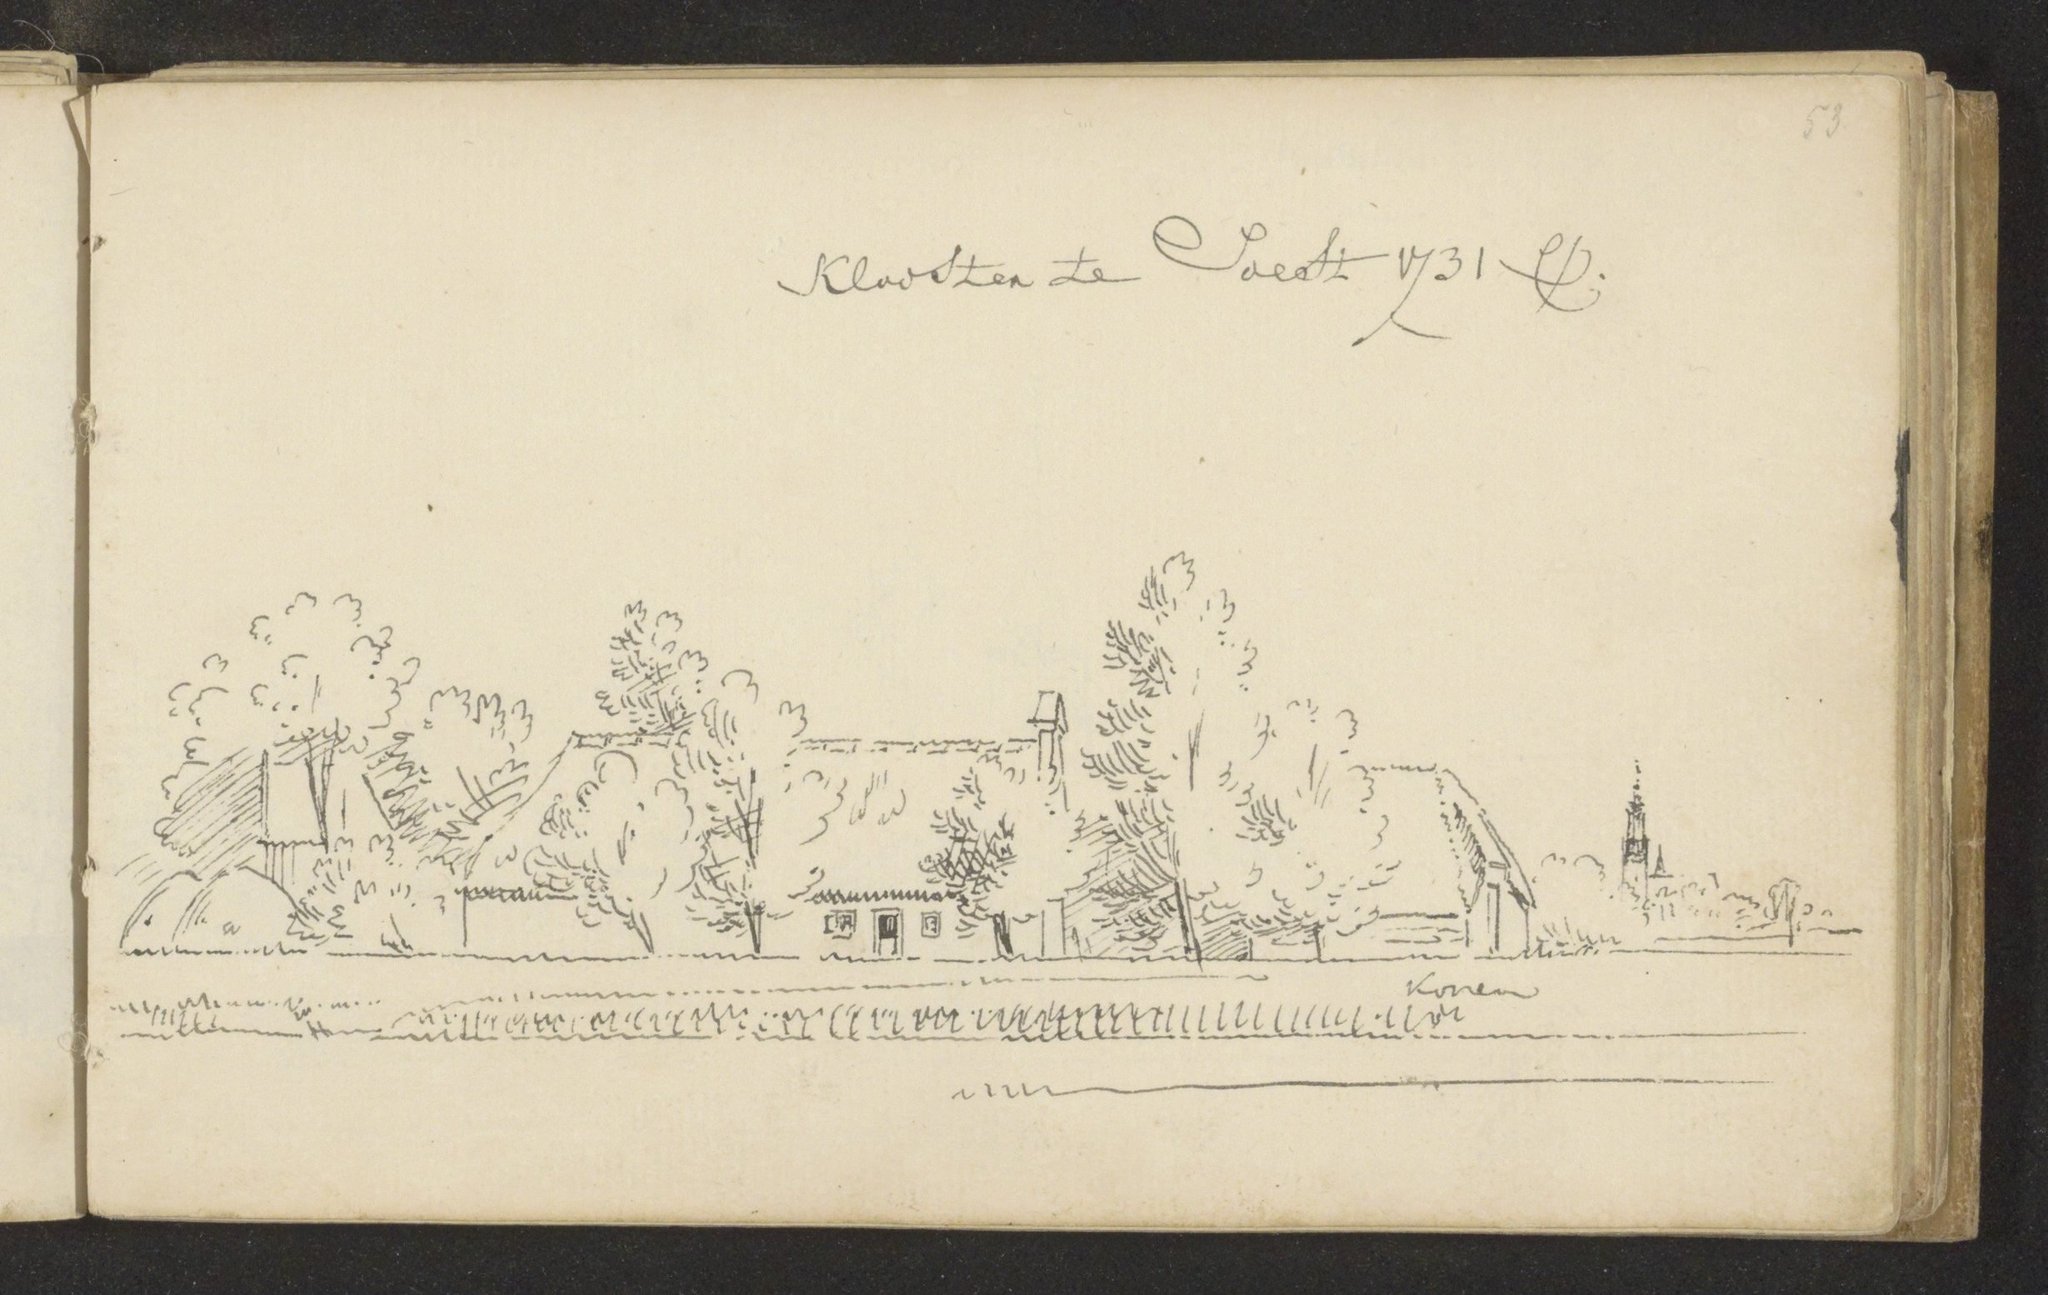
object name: sketchbook leaf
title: Klooster te Soest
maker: abraham de haen (ii)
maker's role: draughtsman, print maker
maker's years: 1707-1748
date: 1731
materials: ink, paper, pencil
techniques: pen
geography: soest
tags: abbey, monastery, convent ~ roman catholic church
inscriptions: date and inscription: ‘Klooster te Soest 1731 CP.’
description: Blad 53 recto uit een schetsboek met 78 bladen.